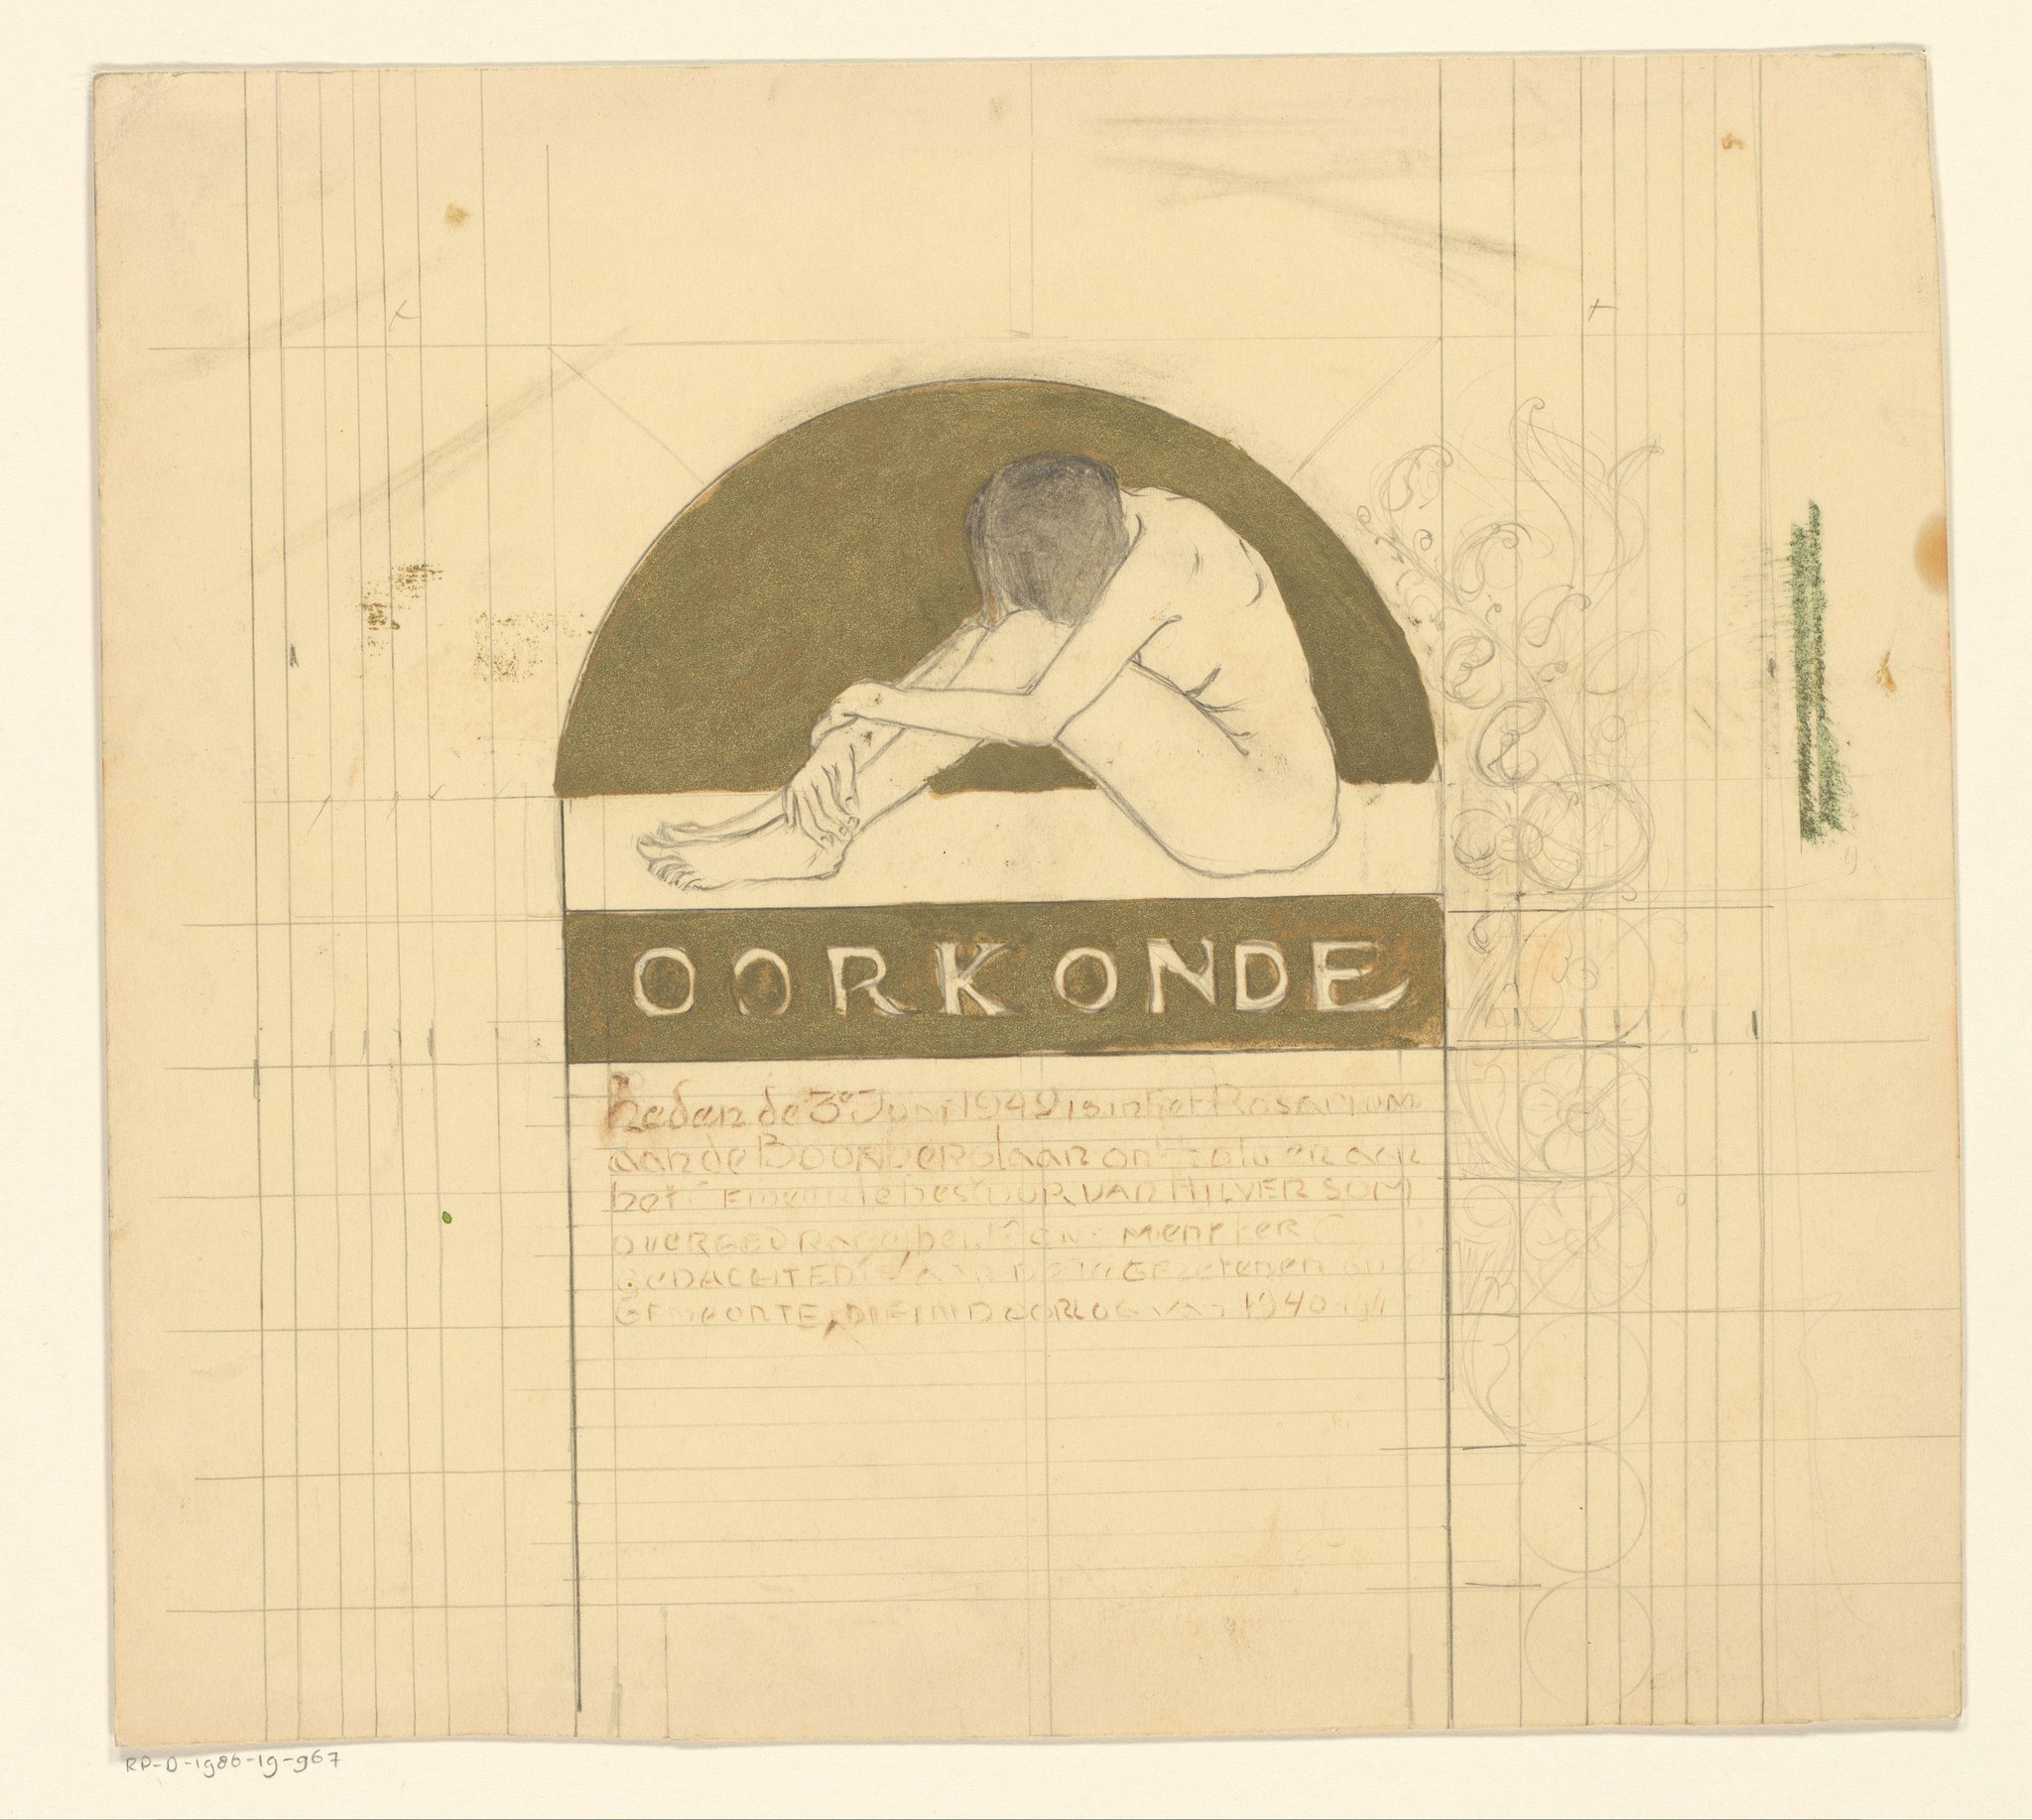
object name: drawing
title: Ontwerp voor een oorkonde ter gelegenheid van de onthulling van het verzetsmonument van Hilversum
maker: reinier willem petrus de vries (1874-1953)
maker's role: draughtsman, print maker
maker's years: 1874-1953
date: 1949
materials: chalk, paint, paper, pencil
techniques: brush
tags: the (nude) human figure; 'corpo humano' (ripa) - aa - female human figure (+ sitting), flowers ~ ornament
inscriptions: collector's mark: ‘R:MVS.’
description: Het betreft de onthulling van het verzetsmonument in het Rosarium aan de Boombergselaan te Hilversum. Het monument is ontworpen door Prof. Vincent Pieter Semeyn Esser.